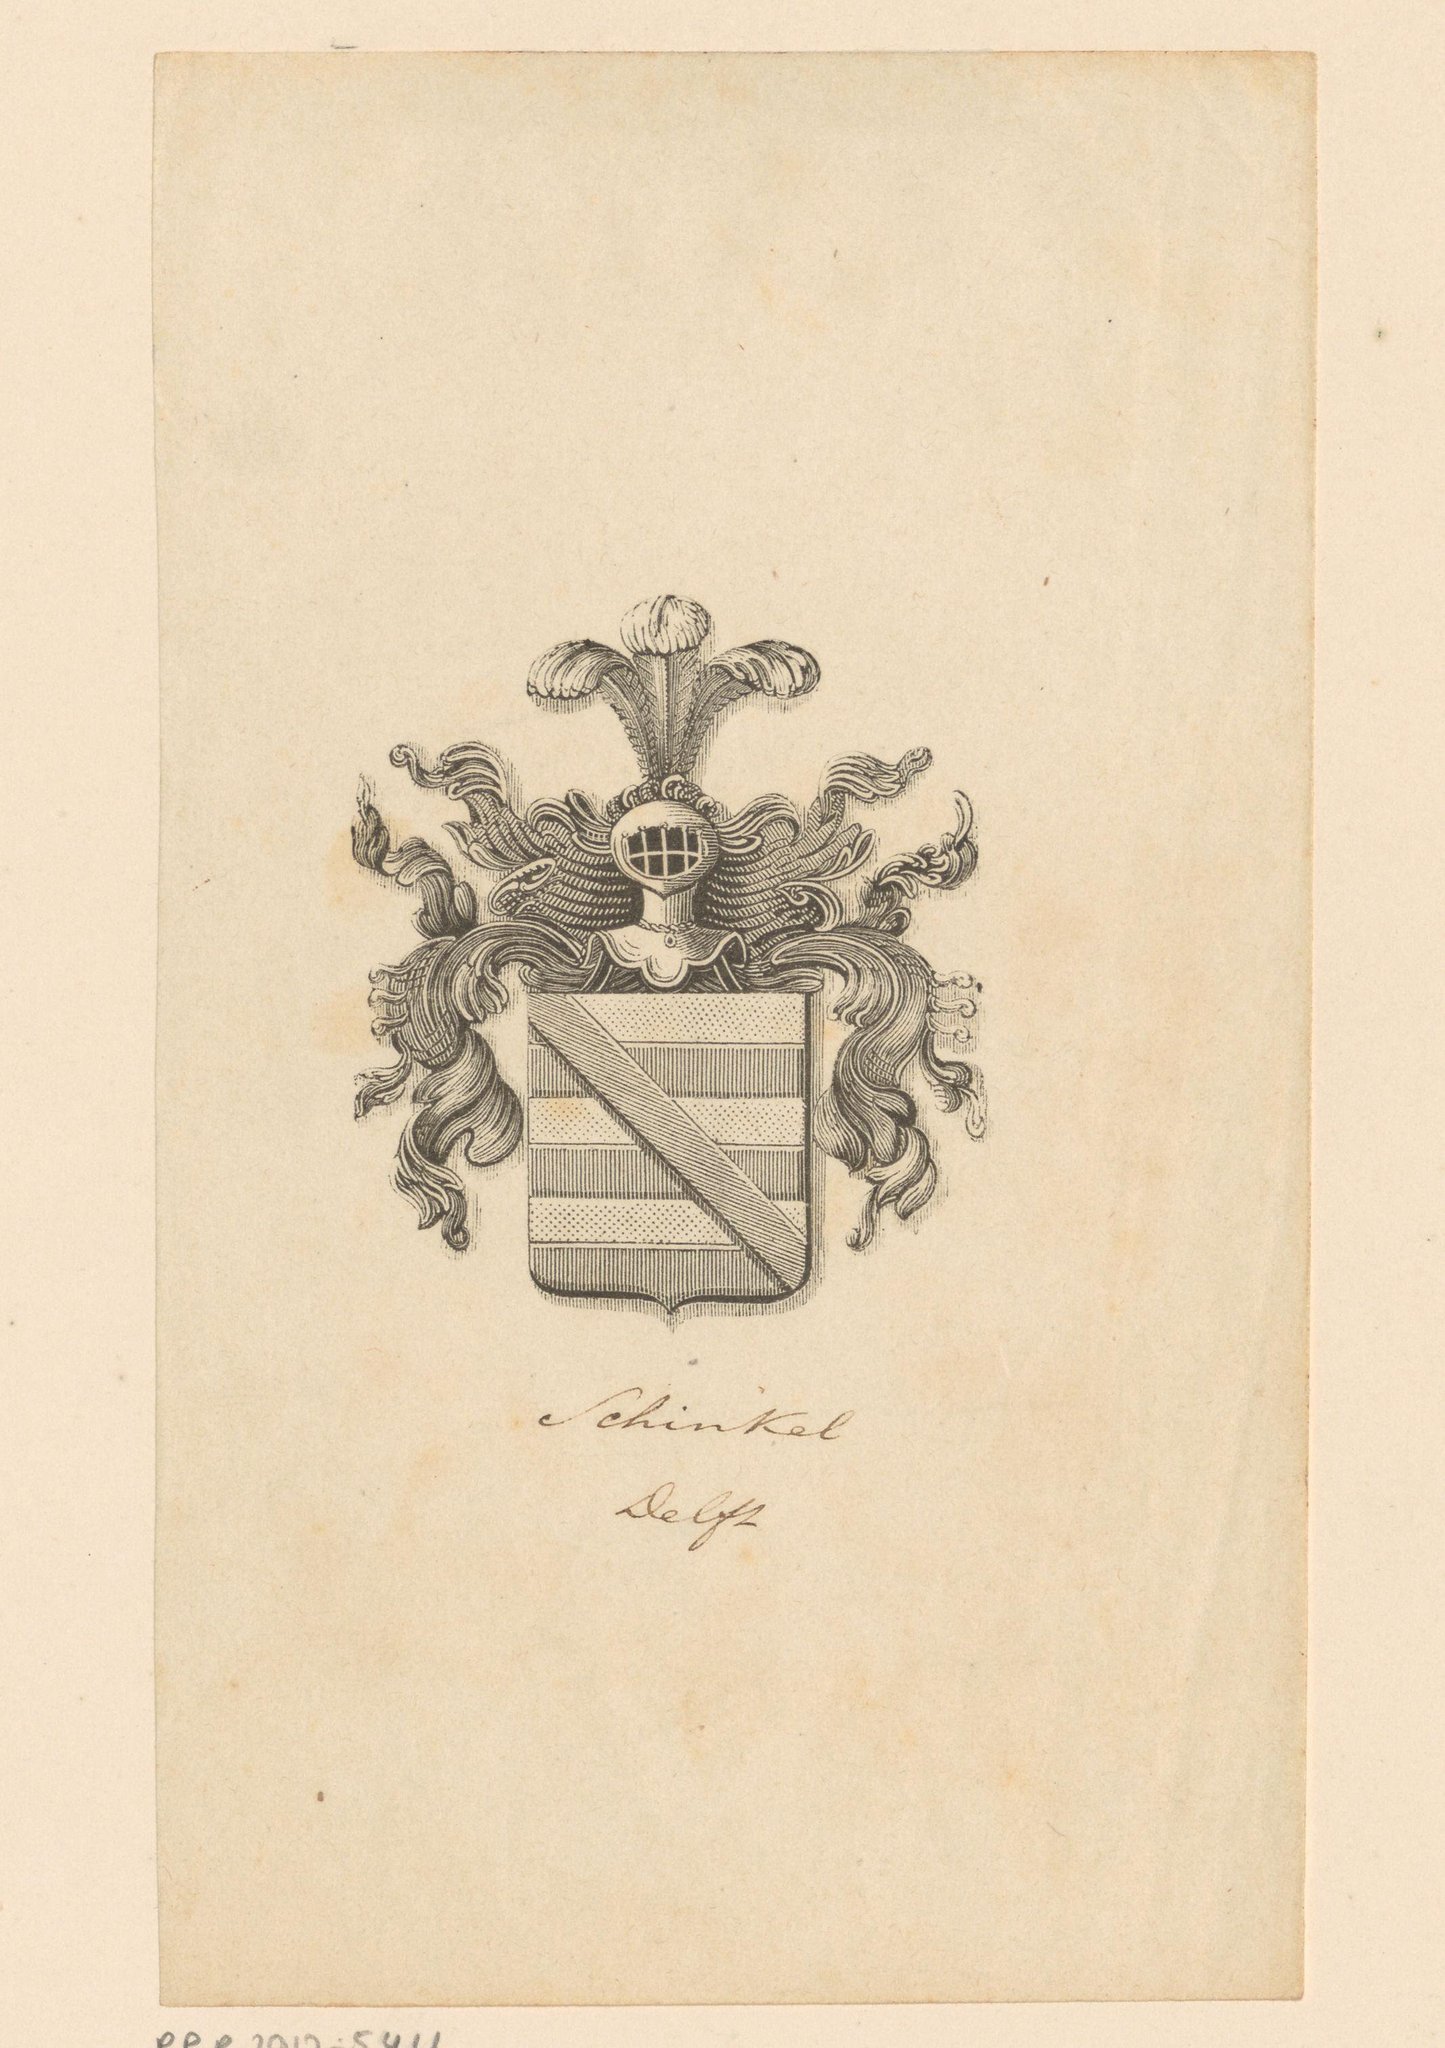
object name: bookplate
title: Ex libris van onbekend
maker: Anonymous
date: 1800-1899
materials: paper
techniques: engraving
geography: netherlands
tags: armorial bearing, heraldry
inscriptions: inscription: ‘Schinkel / Delft’, inscription: ‘Rietstap, 2, 703.’